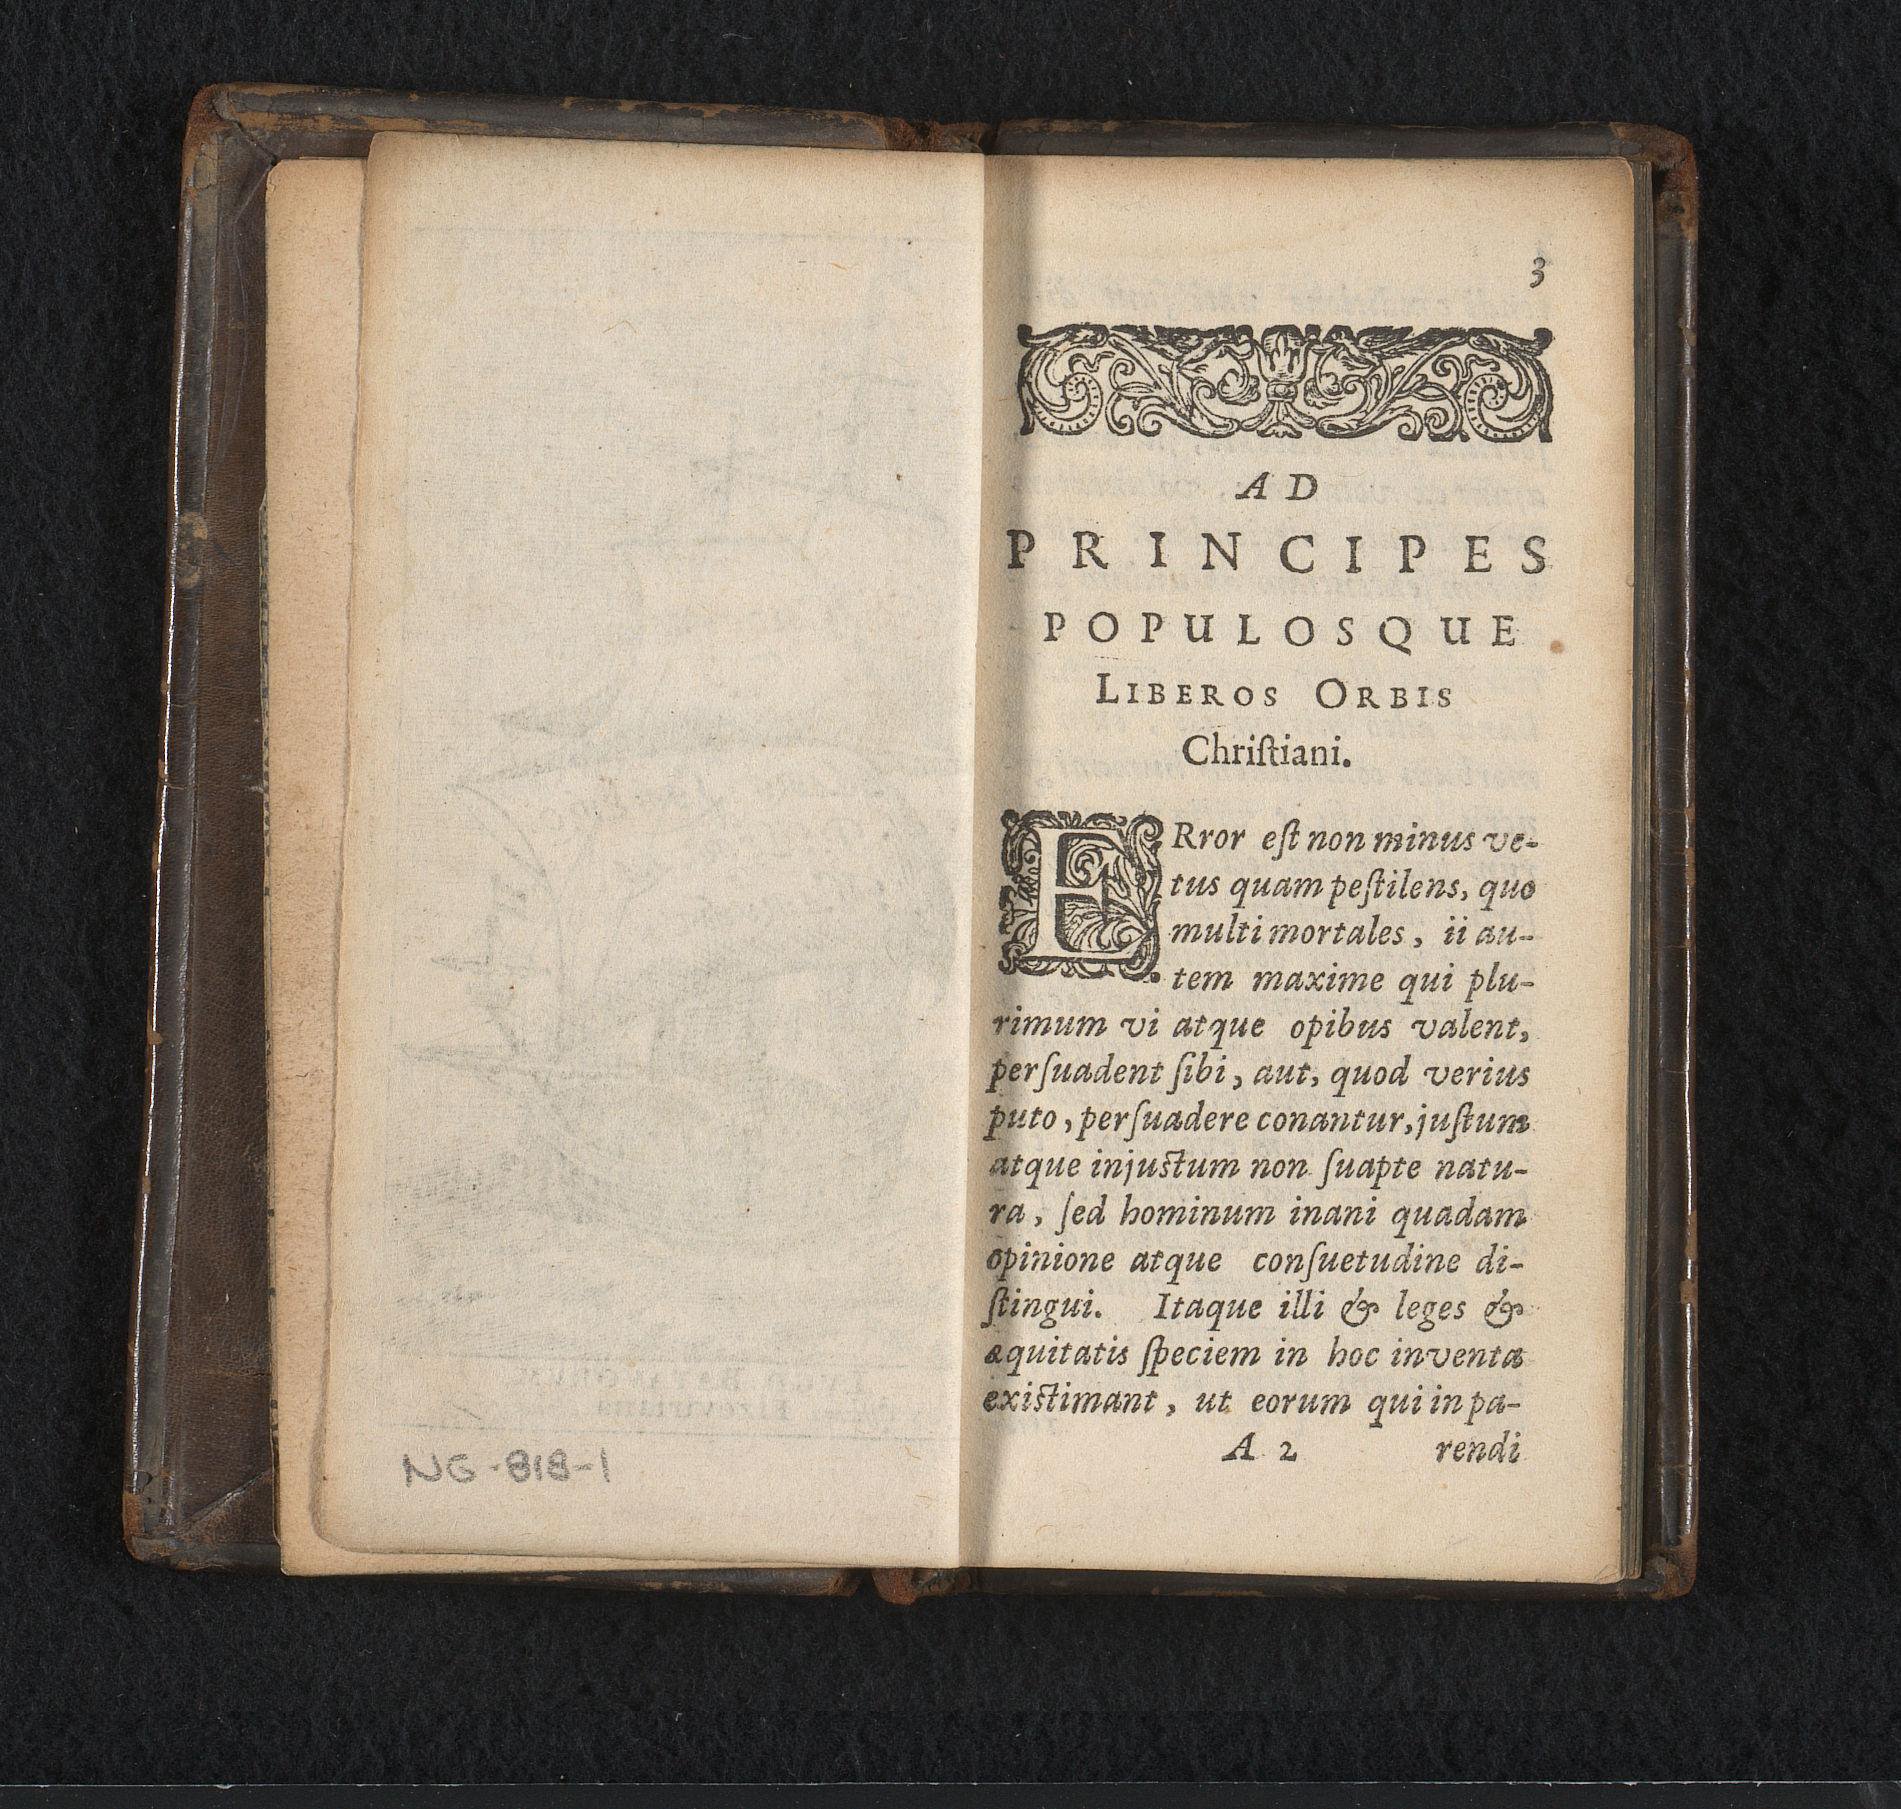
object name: book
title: De mari libero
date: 1633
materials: cardboard, ink, leather, paper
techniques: bookbinding, printing, engraving, pen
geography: leiden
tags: delft, hugo de groot, paulus merula, book, law and jurisprudence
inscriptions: inscription: ‘GR’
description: Gezamenlijke uitgave van Hugo de Groots 'Mare liberum sive de ivre quod Batavis competit ad Indicana commercia, dissertatio' en Paulus Merula's 'Dissertatio de maribus'. Kleine band bevat 308 genummerde pagina's, vier schutbladen voorin en zes schutbladen achterin. Tekst in het Latijn. Drie van de schutbladen voor- en achterin zijn fragmenten van een andere tekst.